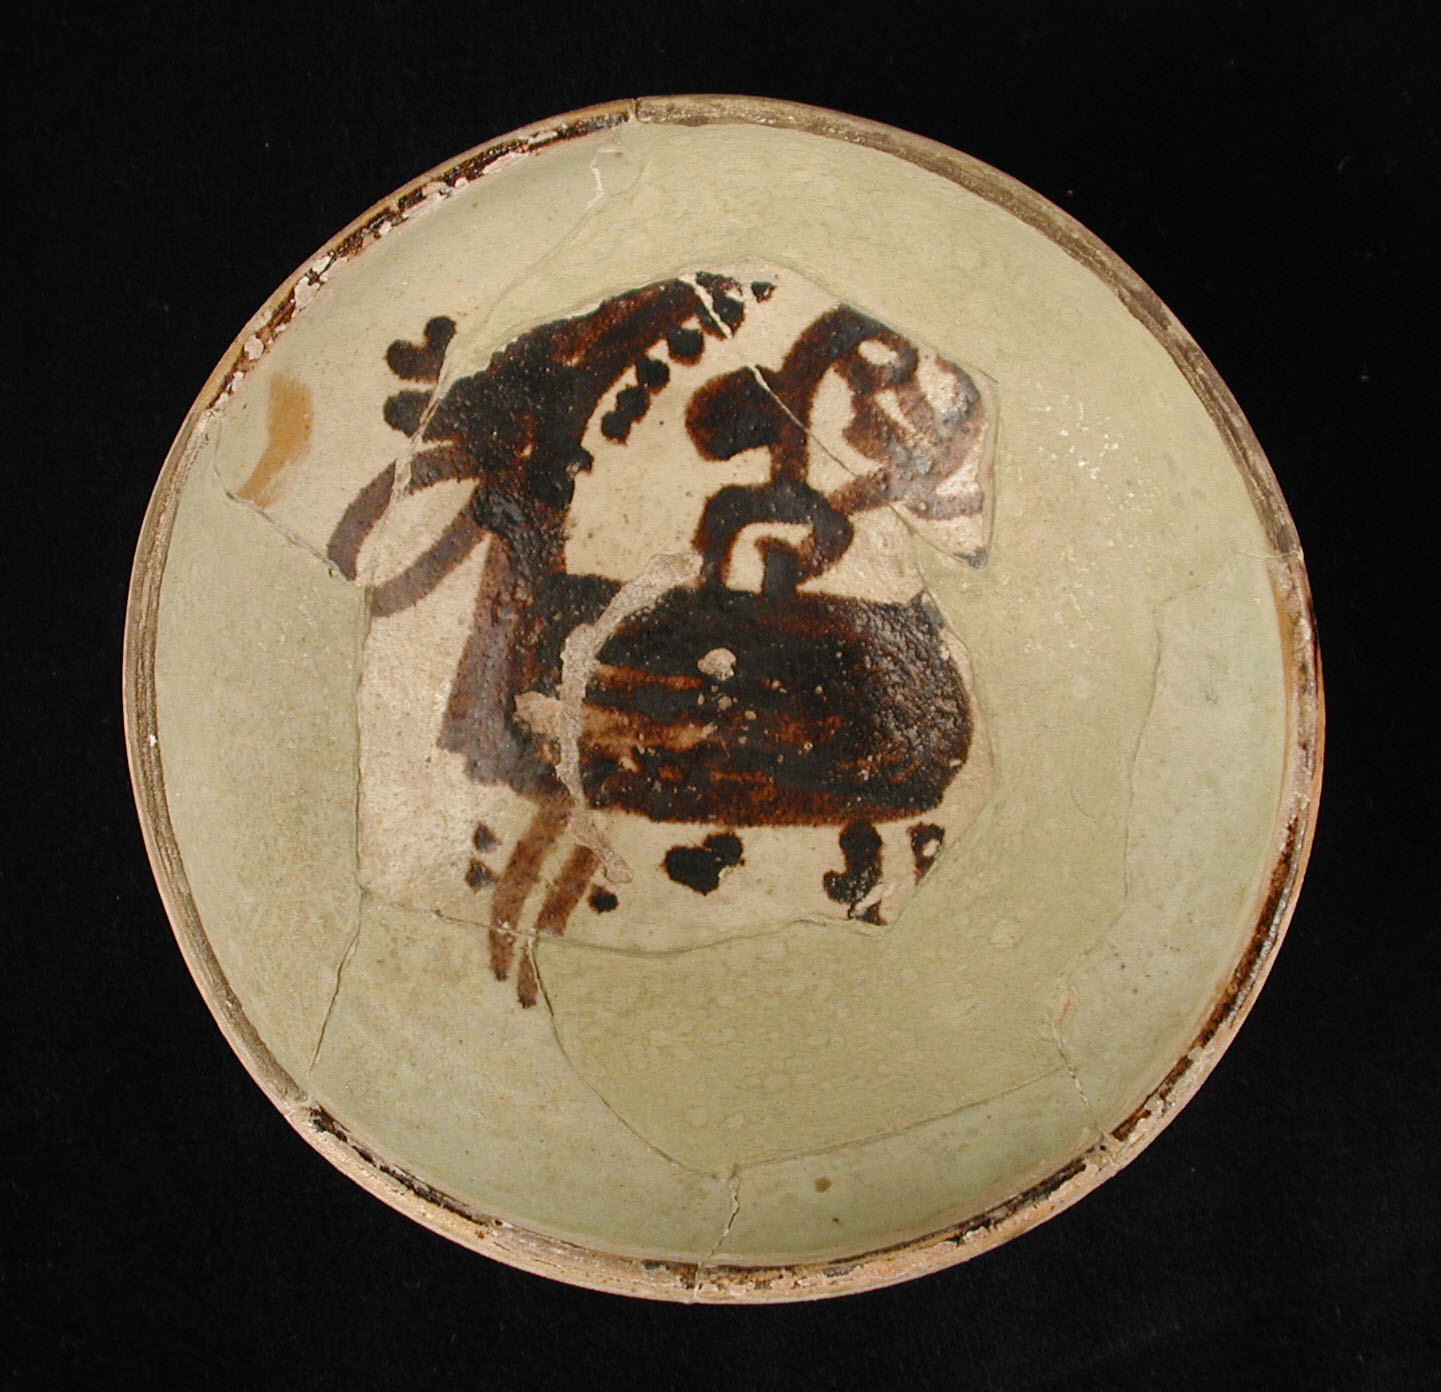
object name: bowl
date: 801-900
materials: earthenware, glaze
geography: iran